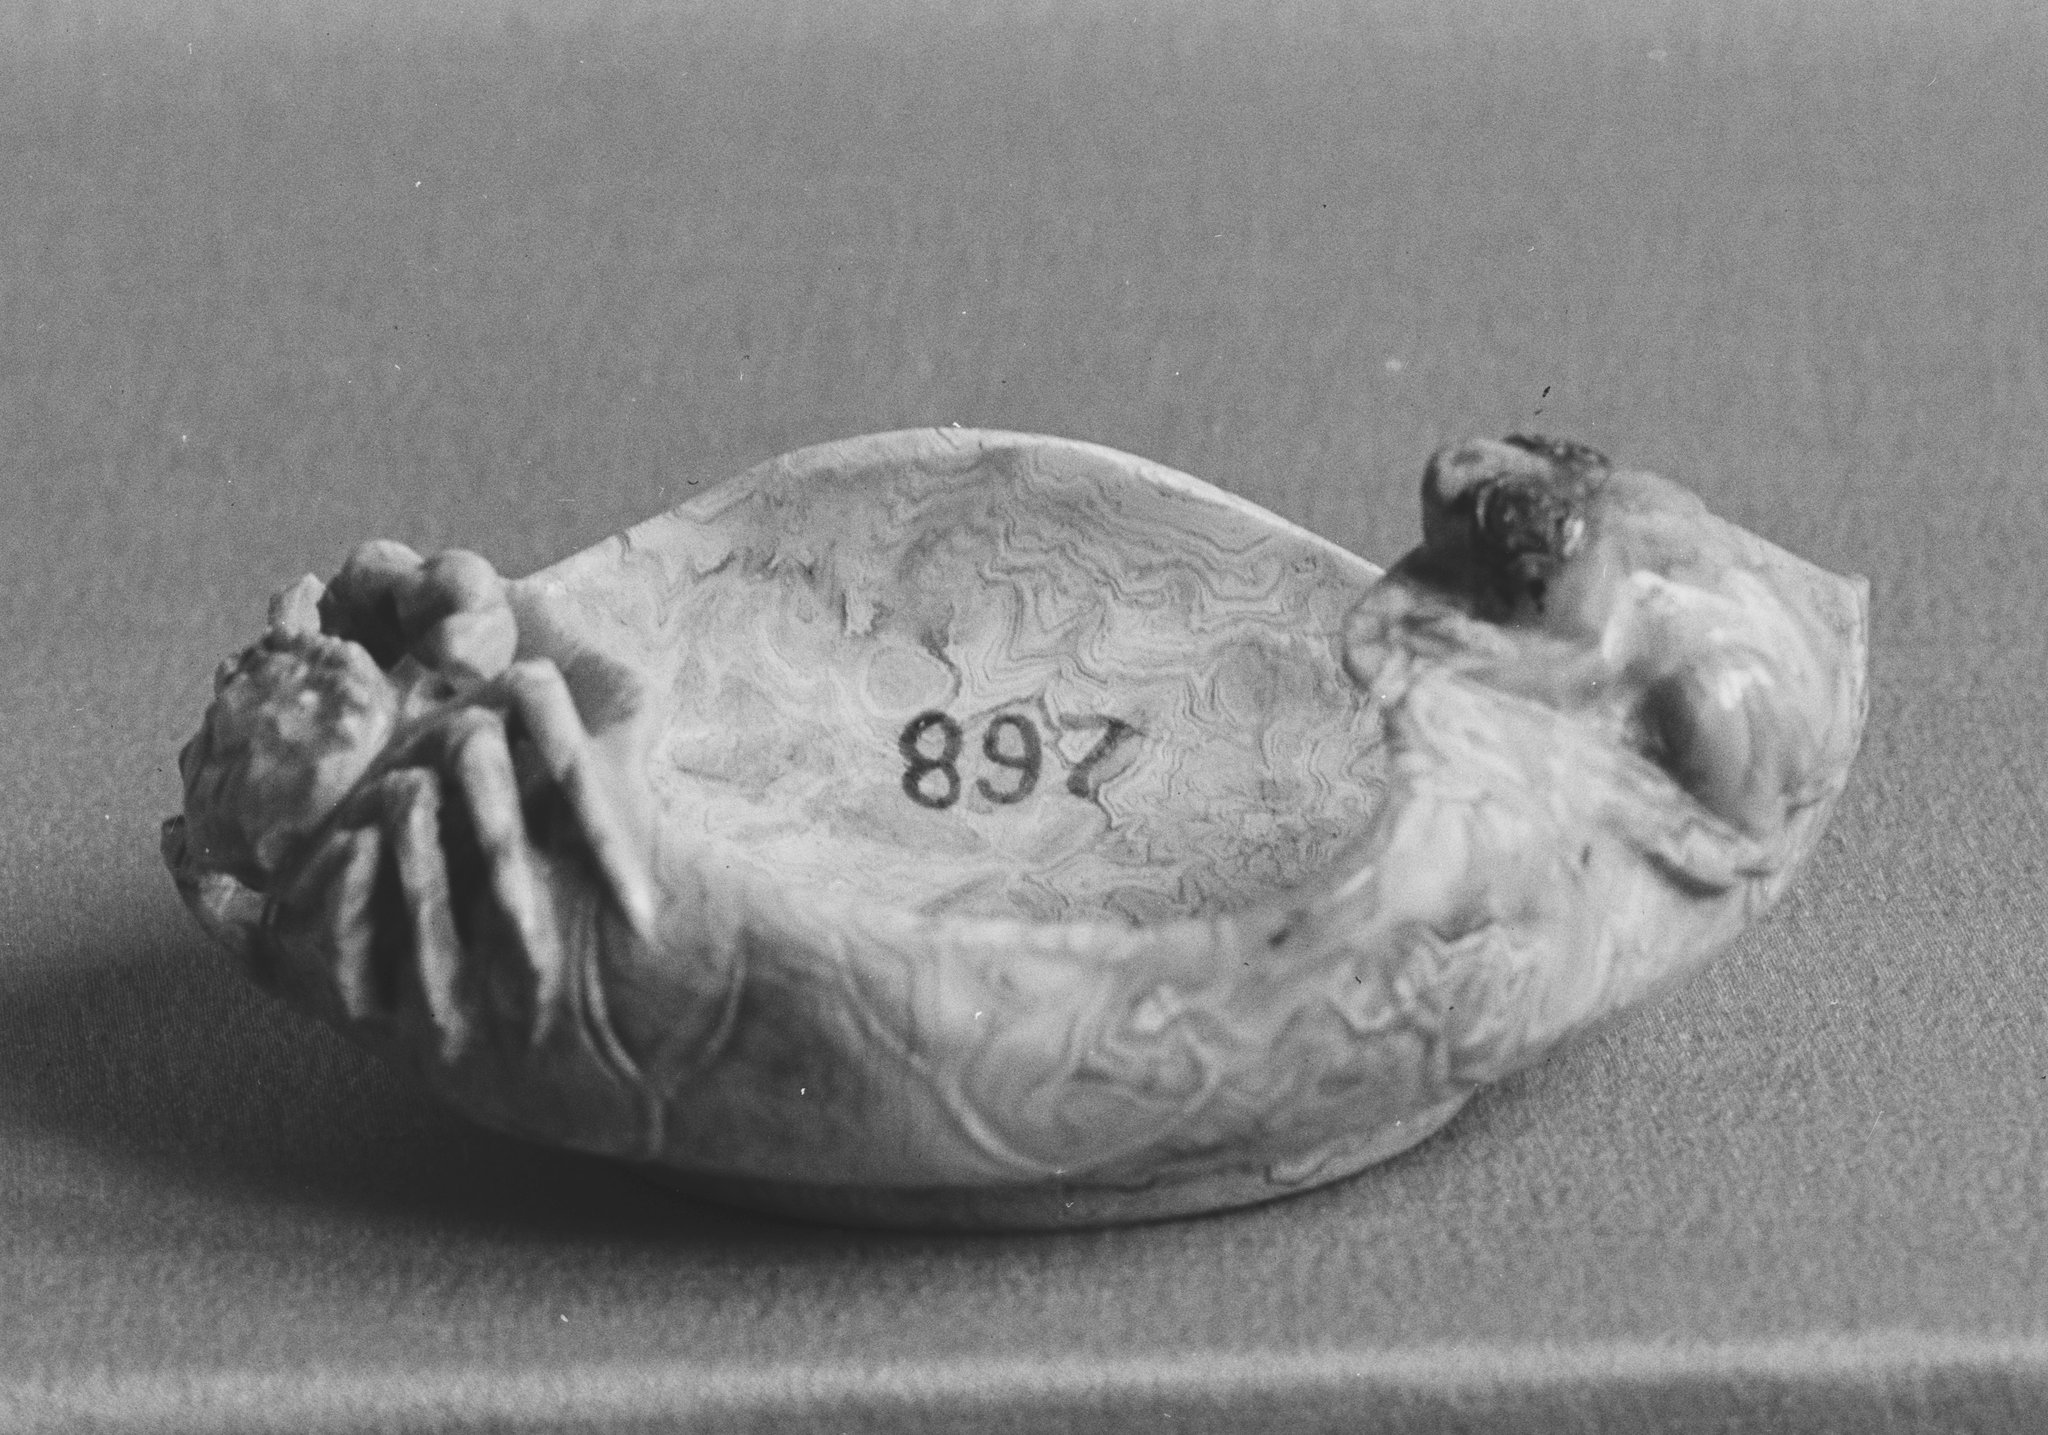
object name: dish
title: Dish with frog and crab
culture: chinese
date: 1701-1800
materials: stone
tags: crabs,frogs